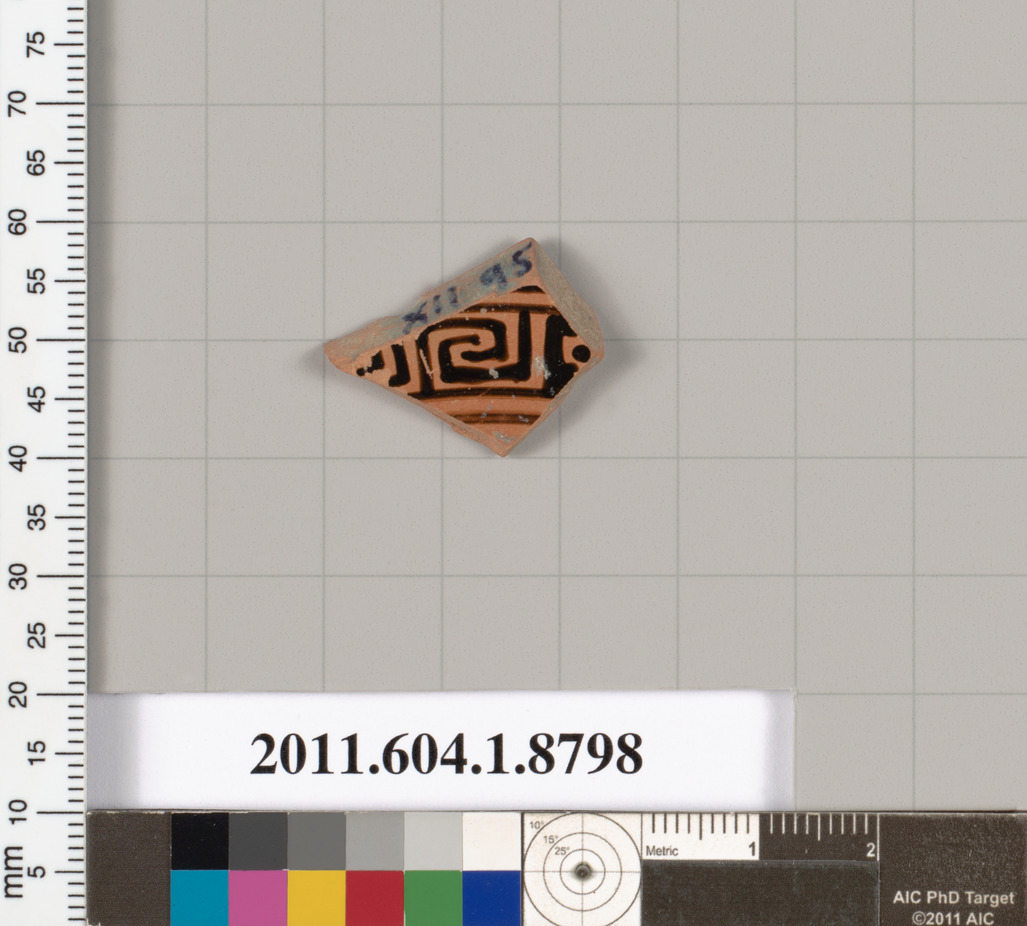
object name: kylix fragment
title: Terracotta fragment of a kylix (drinking cup)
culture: greek, attic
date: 490-480 BCE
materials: terracotta